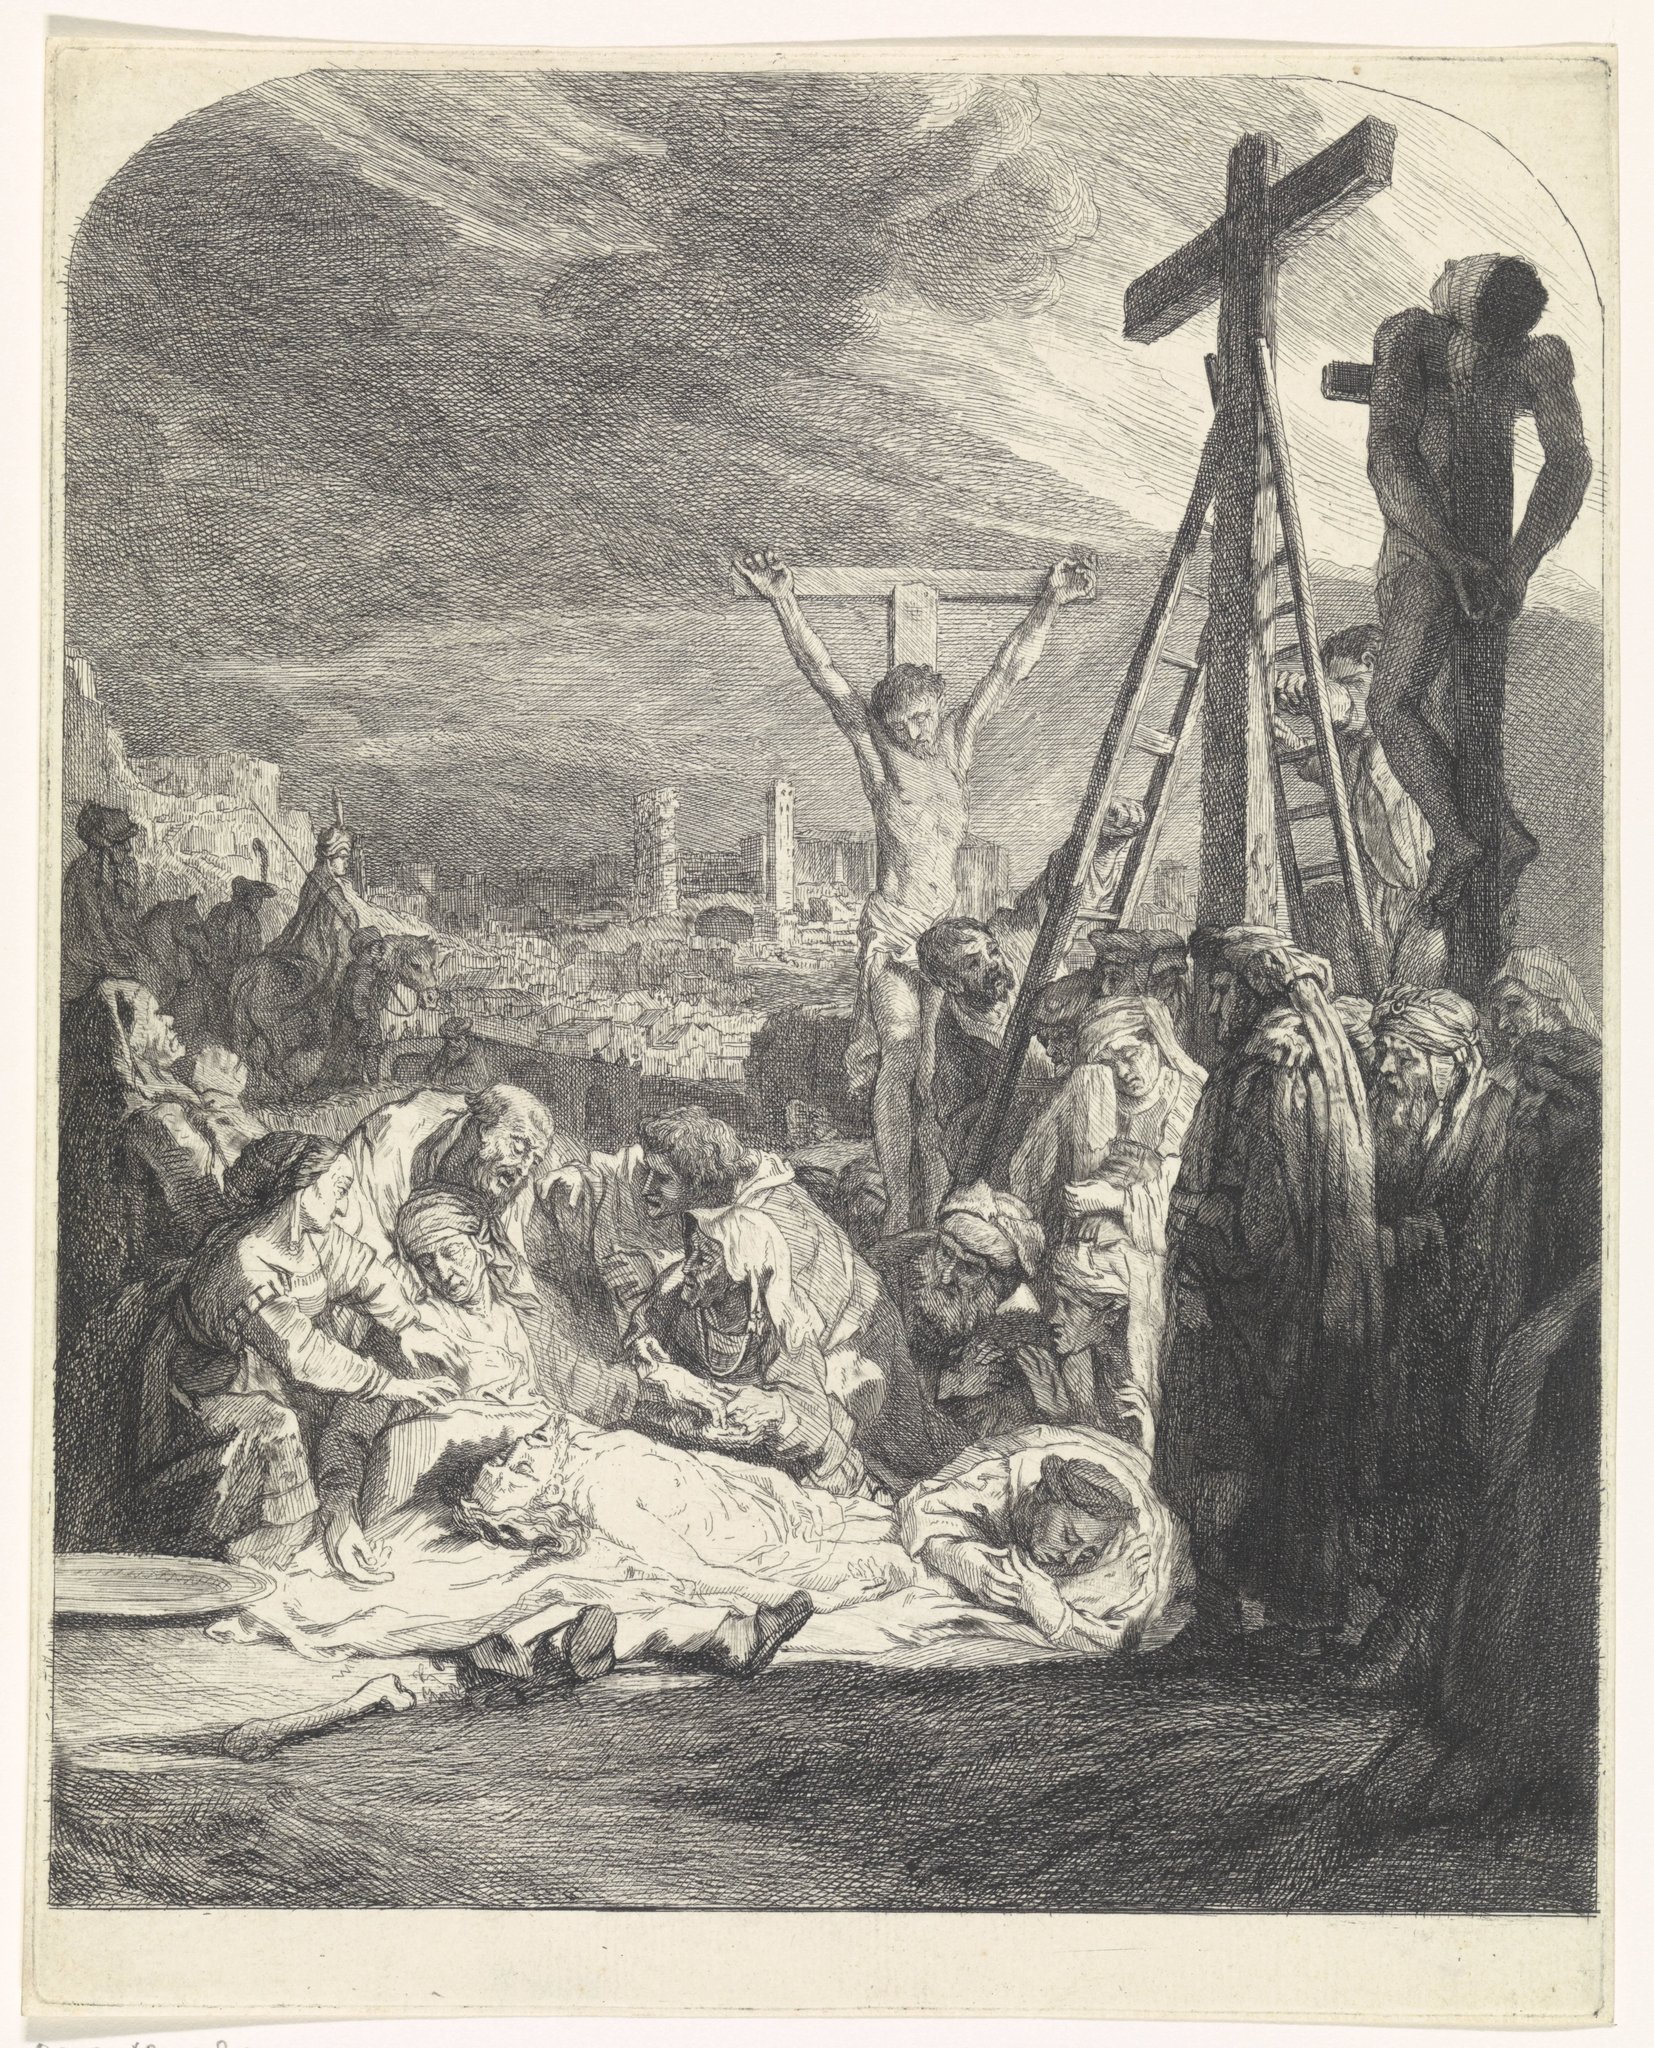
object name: print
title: Bewening van Christus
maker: bernard picart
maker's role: draughtsman, print maker, publisher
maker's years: 1673-1733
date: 1730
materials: paper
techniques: etching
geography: amsterdam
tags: the mourning over the dead christ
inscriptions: collector's mark: Lugt 240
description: Definitieve geletterde staat van deze prent opgenomen in: Impostures innocentes, ou recueil d'estampes d'apres divers peintres (...) par Bernard Picart (...) avec son elogue historique et le catalogue de ses ouvrages. Amsterdam: weduwe Bernard Picart, 1734.